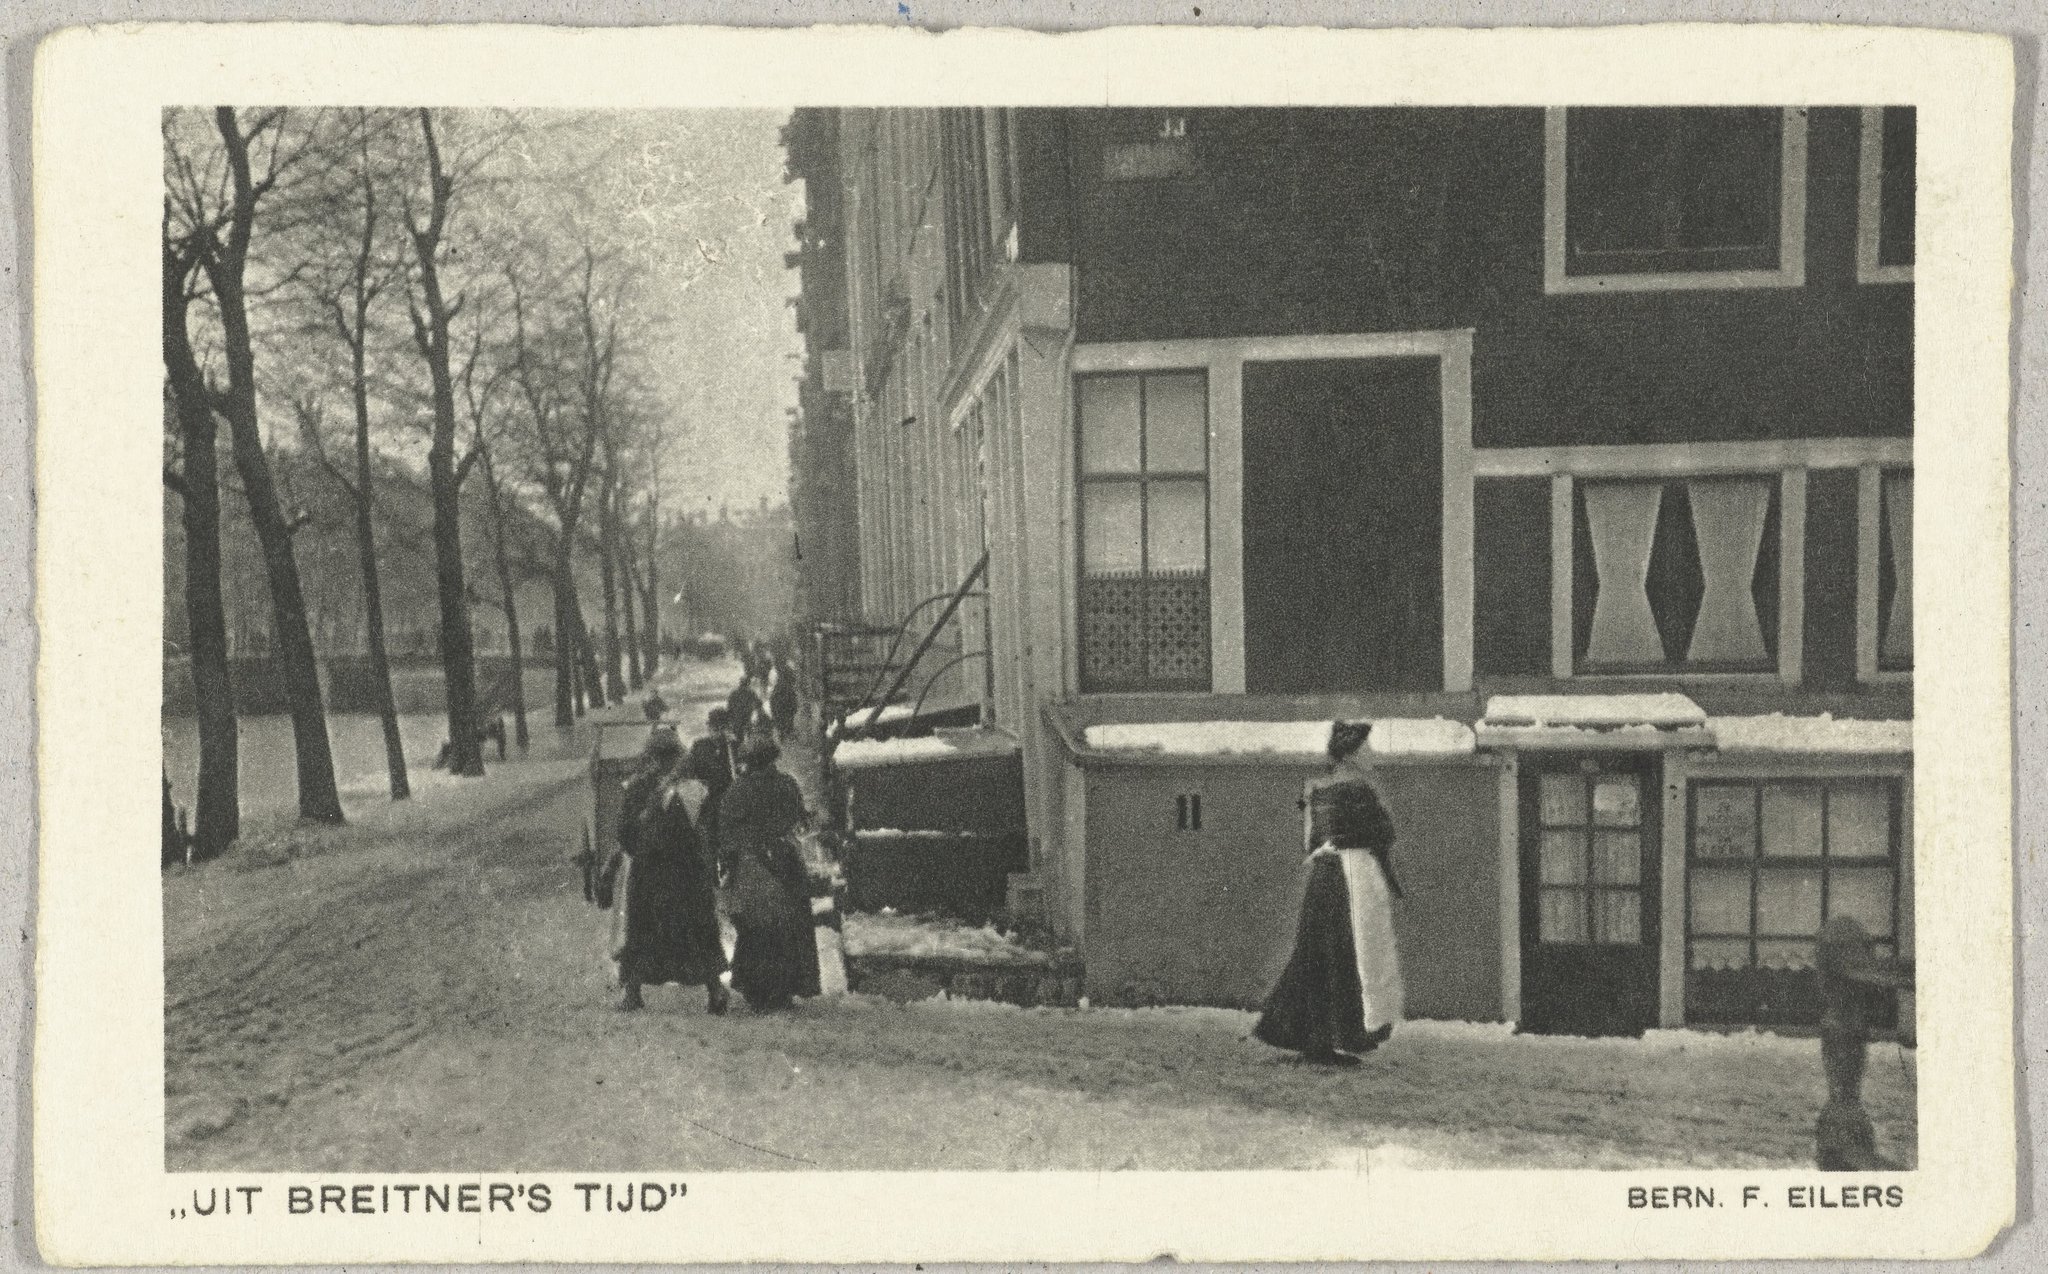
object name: photograph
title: Herengracht, hoek Leidsegracht, Amsterdam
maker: bernard eilers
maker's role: fotograaf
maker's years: 1878-1951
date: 1913-1940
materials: paper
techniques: rotogravure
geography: amsterdam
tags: snow, street (+ city(-scape) with figures, staffage)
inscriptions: annotation: ‘Serie B Herengracht, hoek Leidsegracht, Amsterdam ("Uit Breitner's tijd")’, name: ‘Bern. F. Eilers’, annotation: ‘Eilers Artistieke kaarten - uitg.-mij. "Kosmos" - Amsterdam’